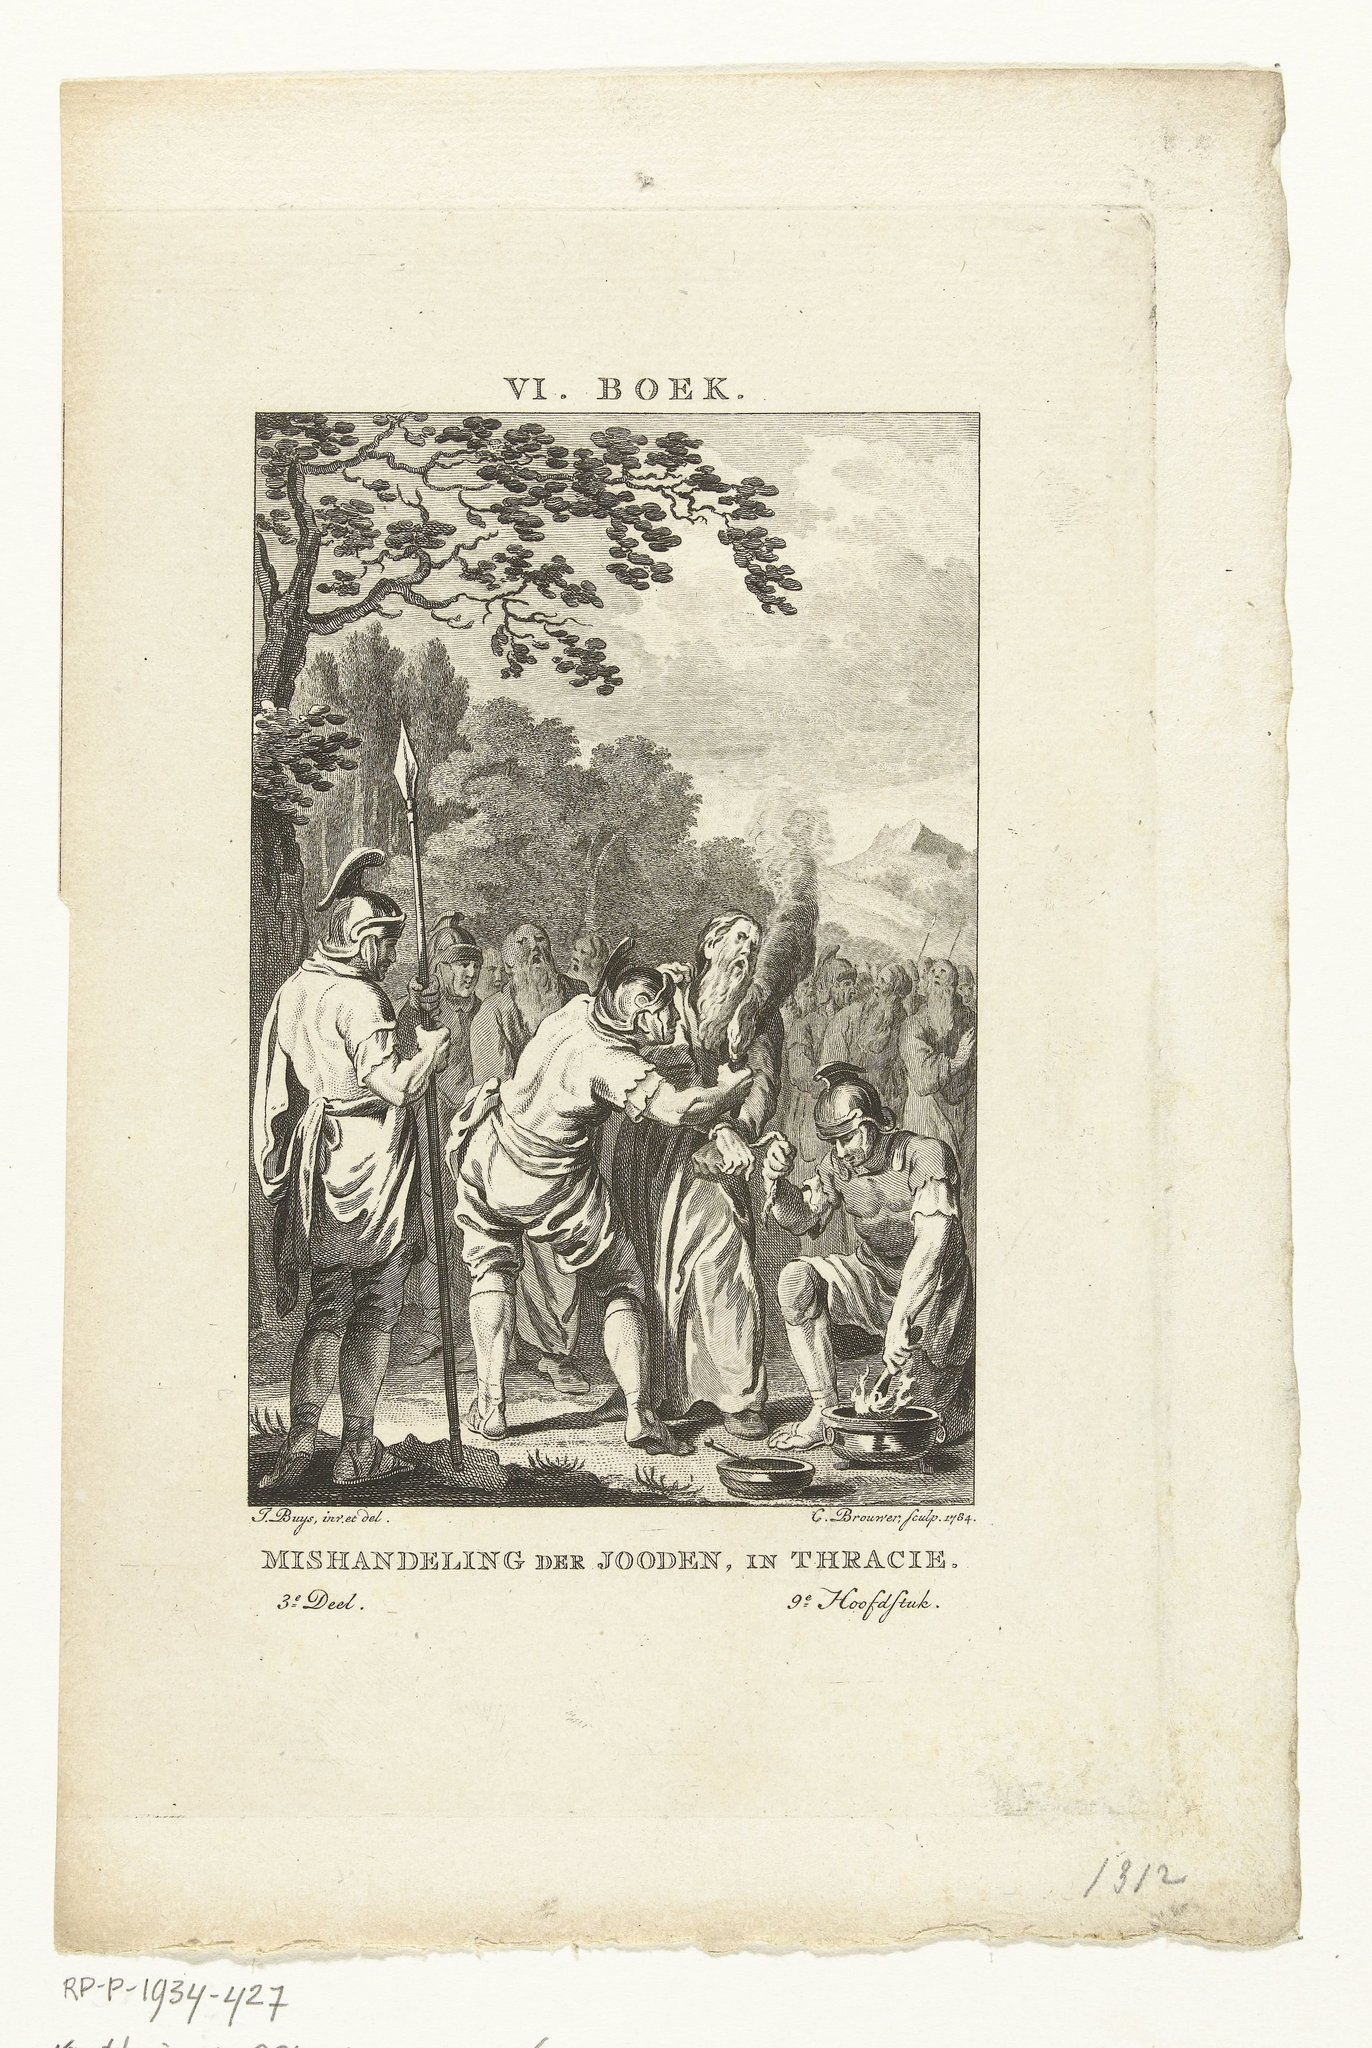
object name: print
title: Mishandeling van de Joden in Thracië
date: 1784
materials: paper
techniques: etching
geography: netherlands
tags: torture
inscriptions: collector's mark: Lugt 2228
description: Prent naar tekening van Jacobus Buys. Vergelijk de voortekening in de collectie van het RMA, inv.nr. RP-T-1913-65. Prent gebruikt voor onbekend uitgave over de Joodse kerkhistorie, boekillustratie bij het zesde boek, derde deel, hoofdstuk 9.